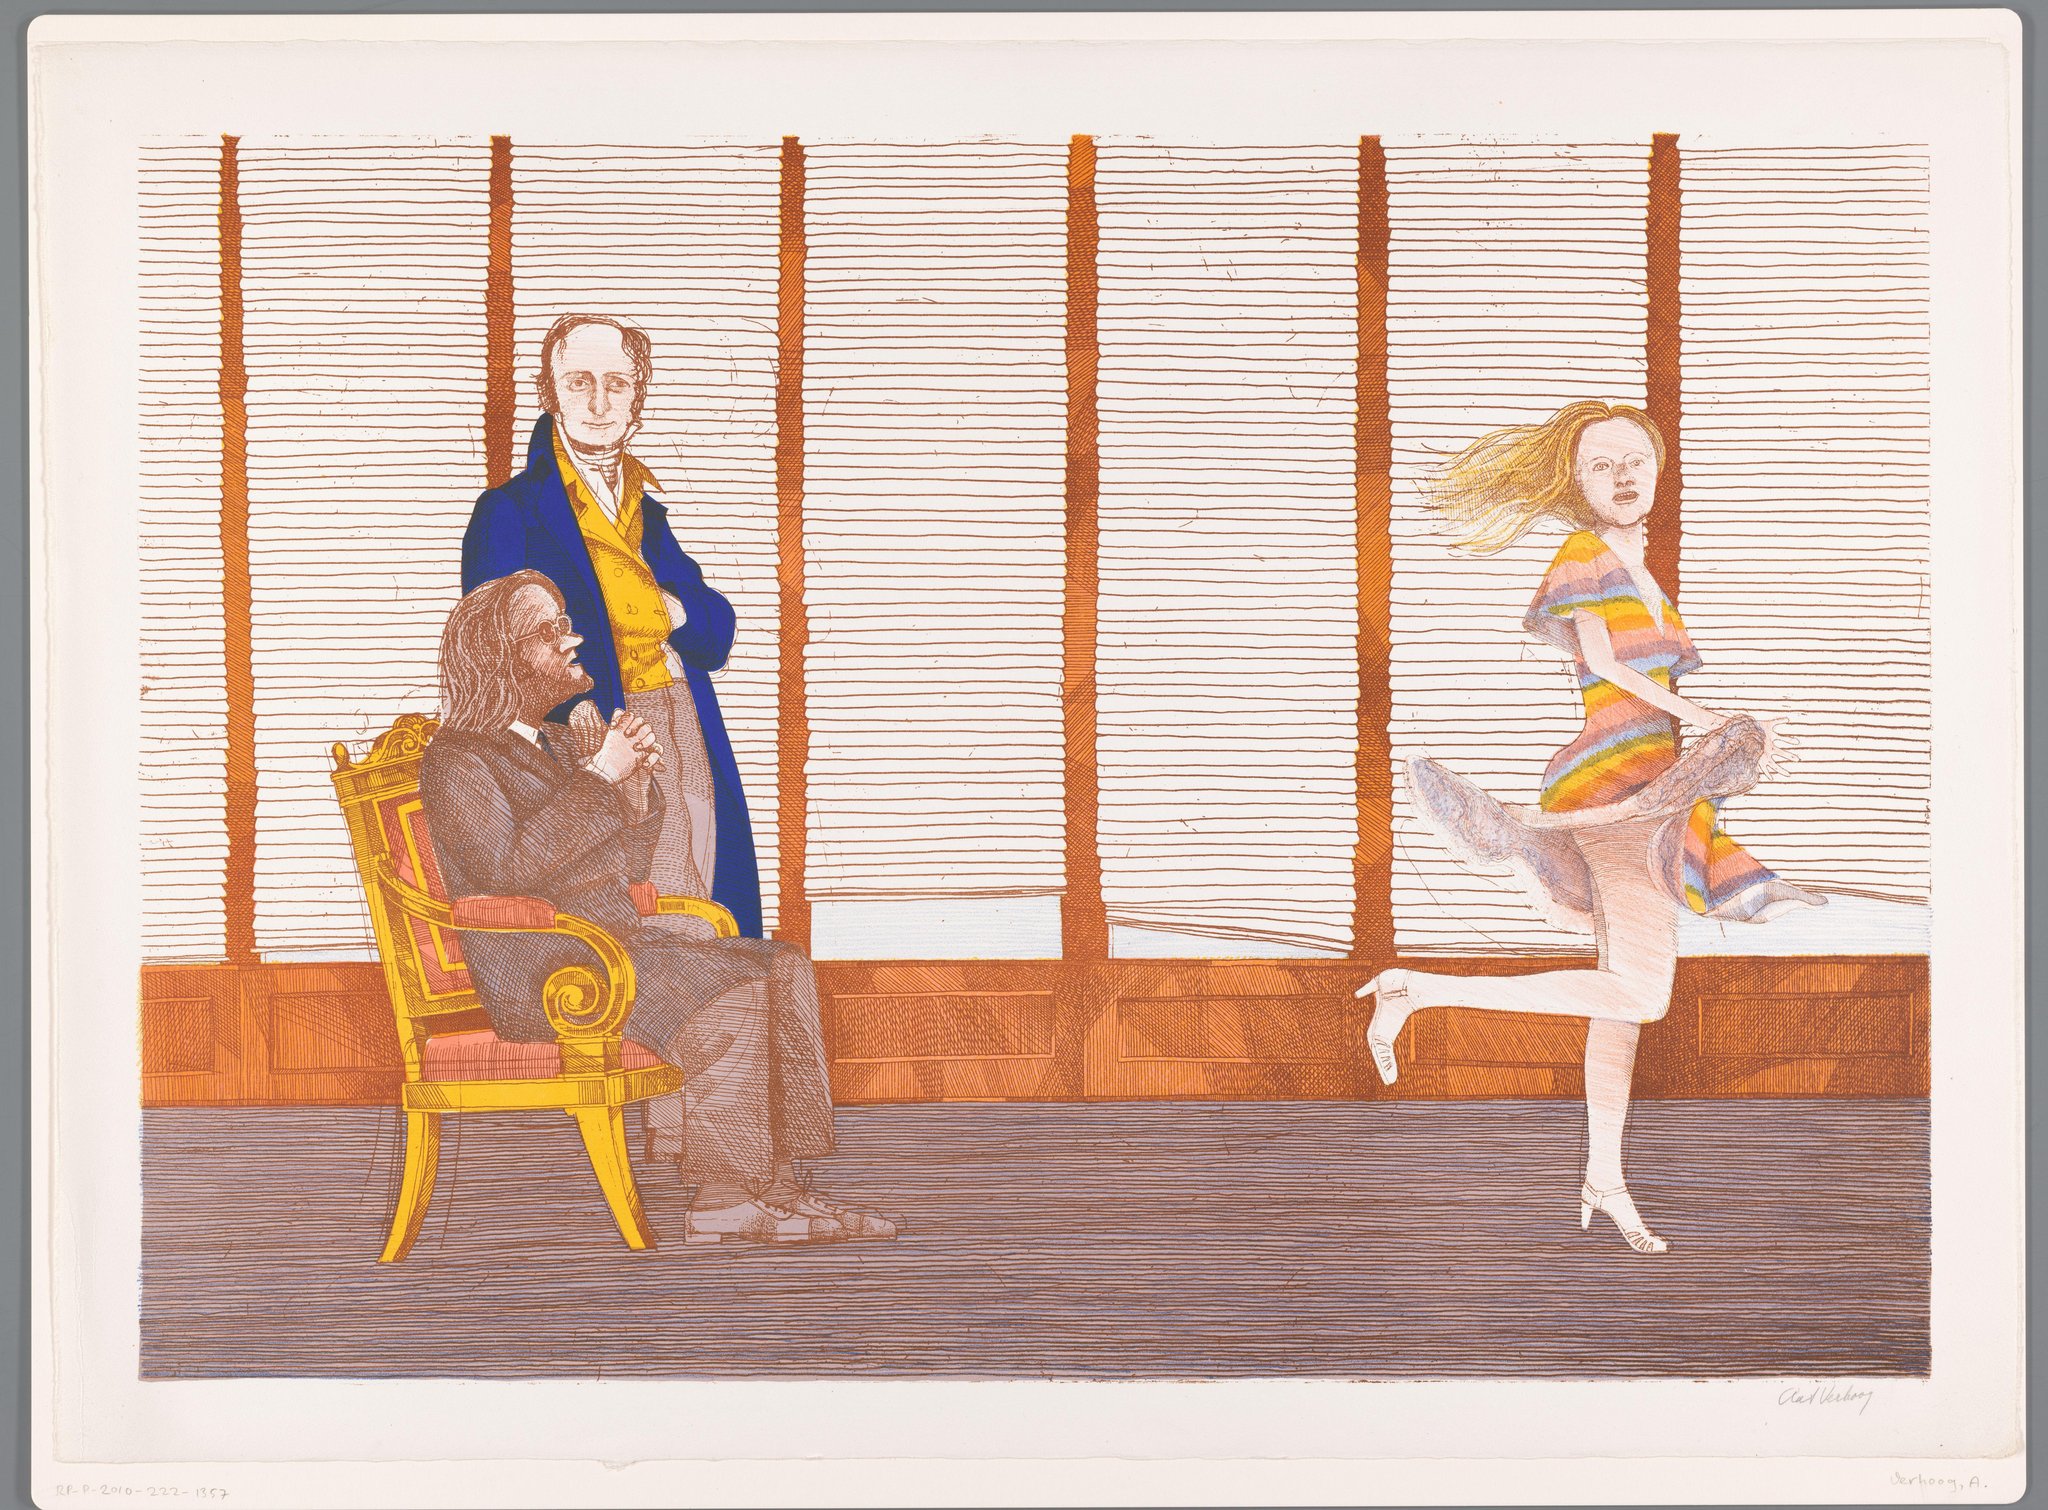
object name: print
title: Dansende vrouw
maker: aat verhoog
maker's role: print maker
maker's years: 1933-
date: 1965-1980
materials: paper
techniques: lithograph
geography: netherlands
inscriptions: signature: ‘Aat Verhoog’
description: Dansende vrouw in regenboogjurken en twee mannen waarvan een zittend en een staand, welke laatste de trekken en uitdossing van Napoleon heeft.